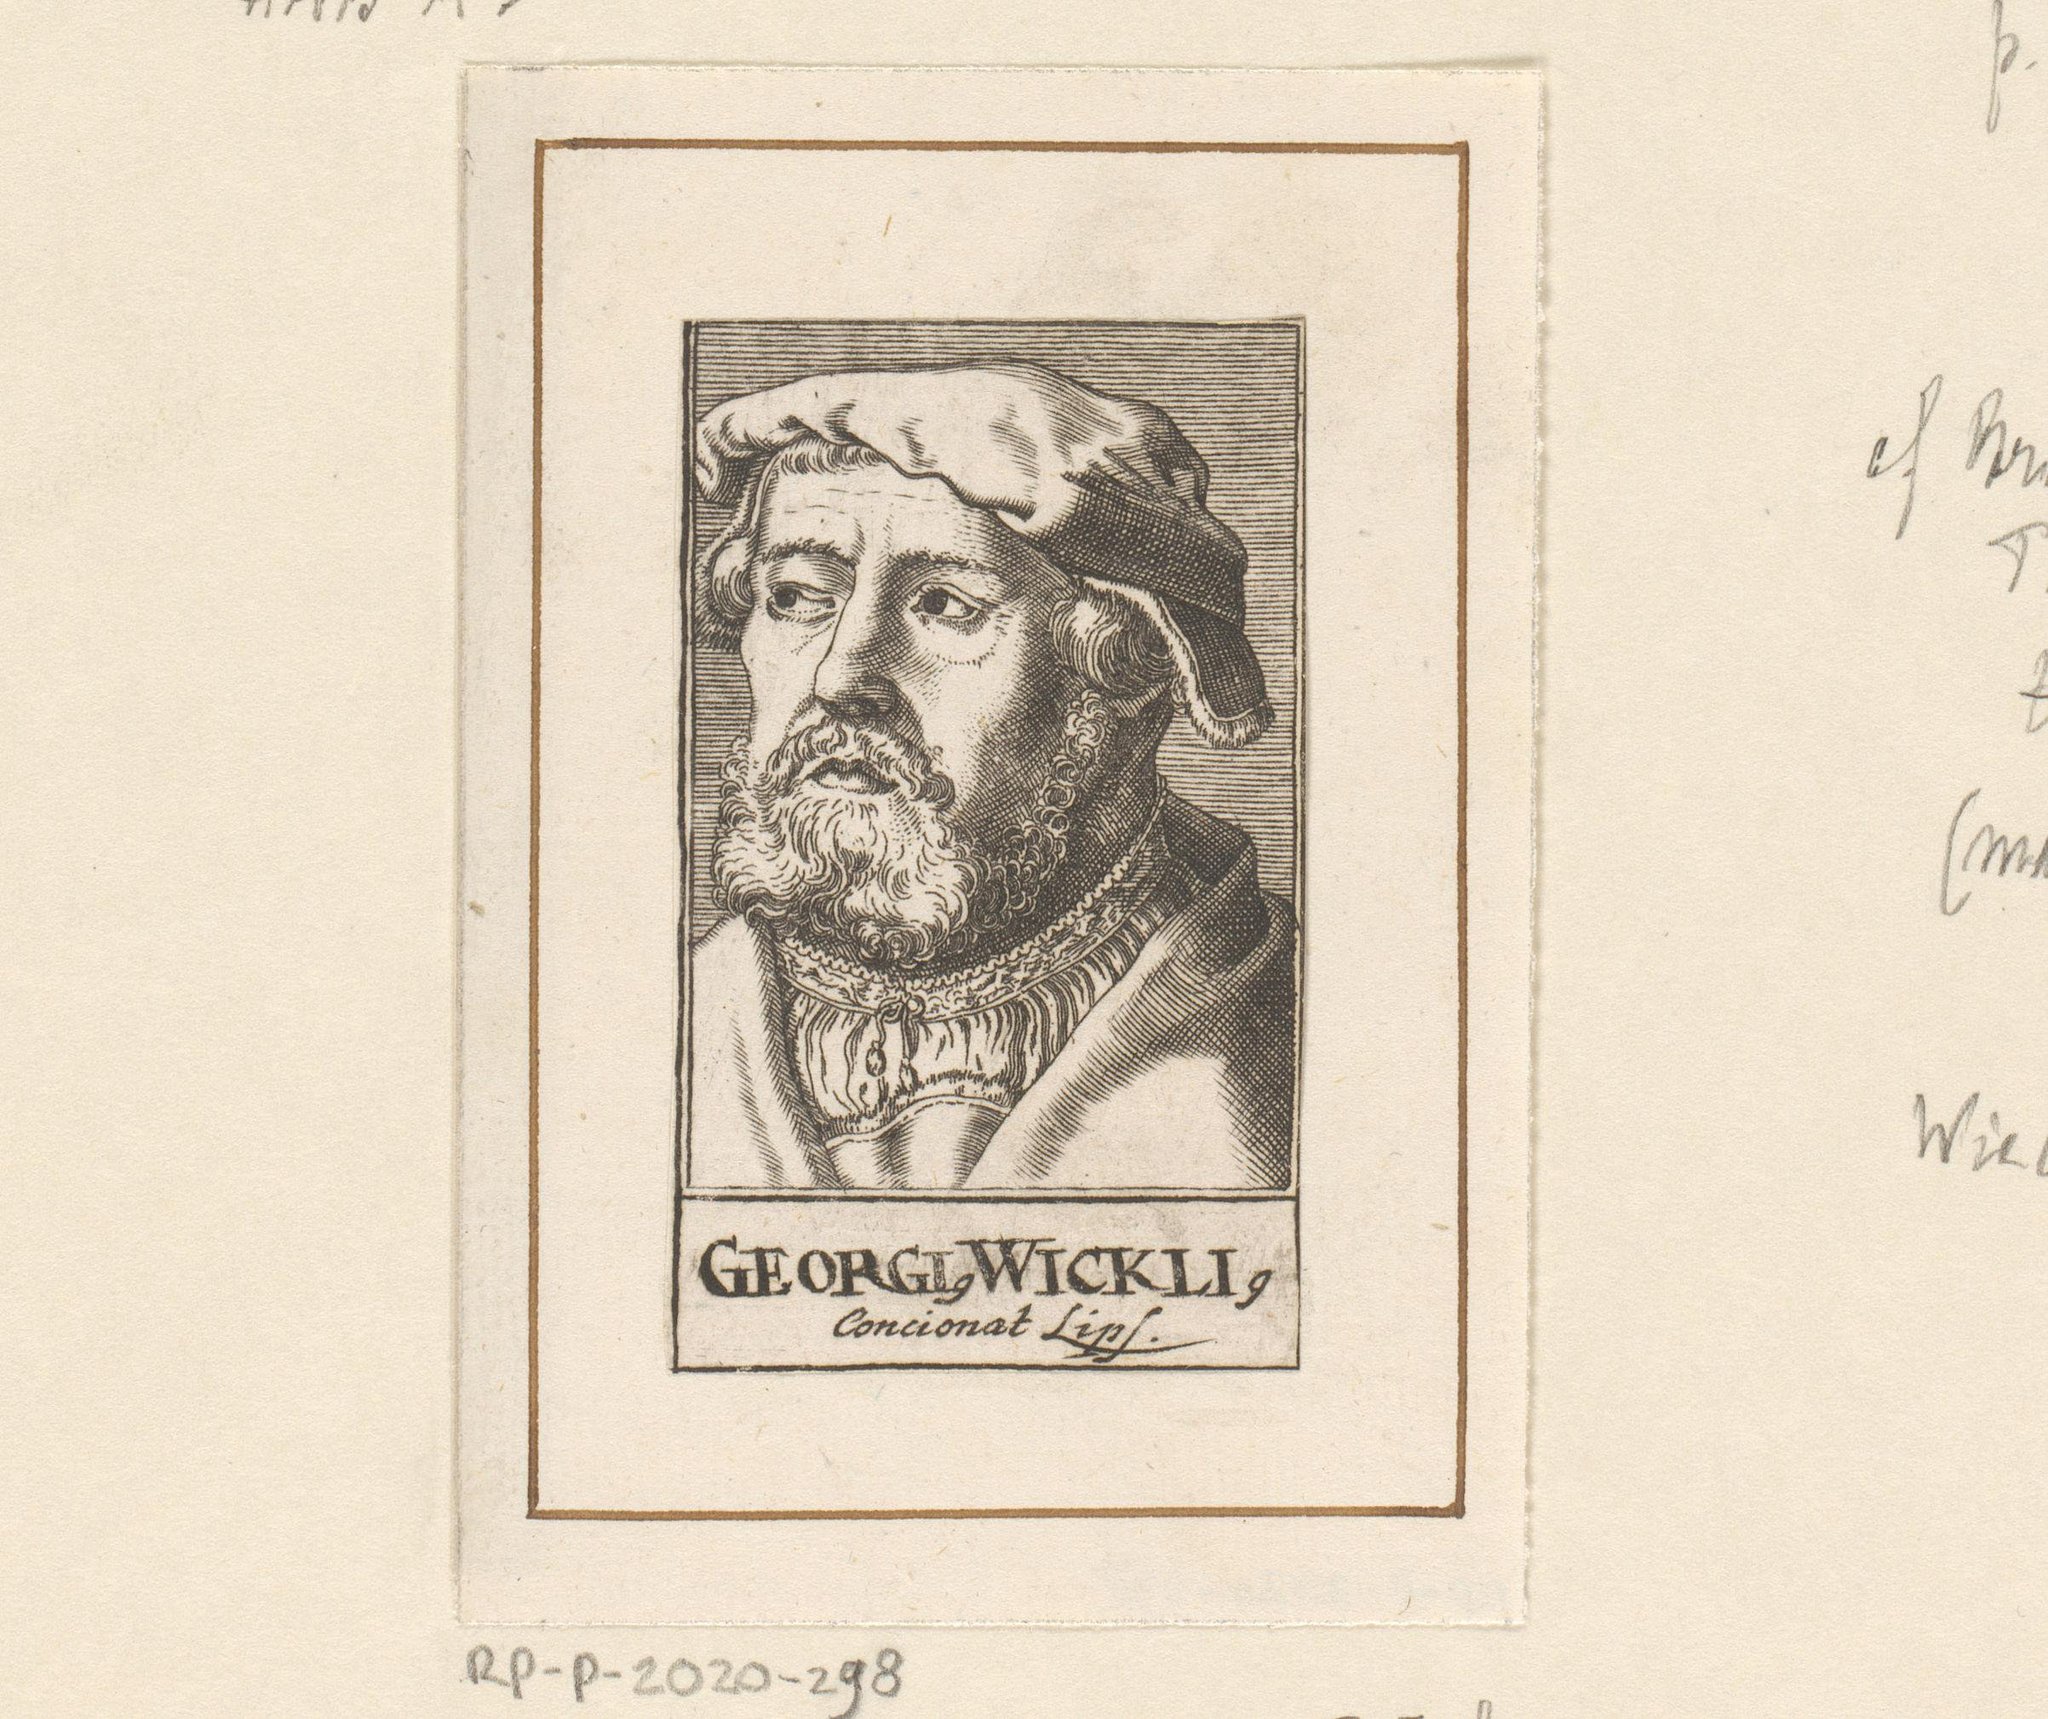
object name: print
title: Georgi[9] Wickli[9] concionat lips.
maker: Anonymous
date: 1688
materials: paper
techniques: engraving, etching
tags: theologian, historical persons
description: Prent gebruikt in: Freher, Paul. Theatrum virorum eruditione clarorum. Neurenberg: Johann Hoffmann, 1688.